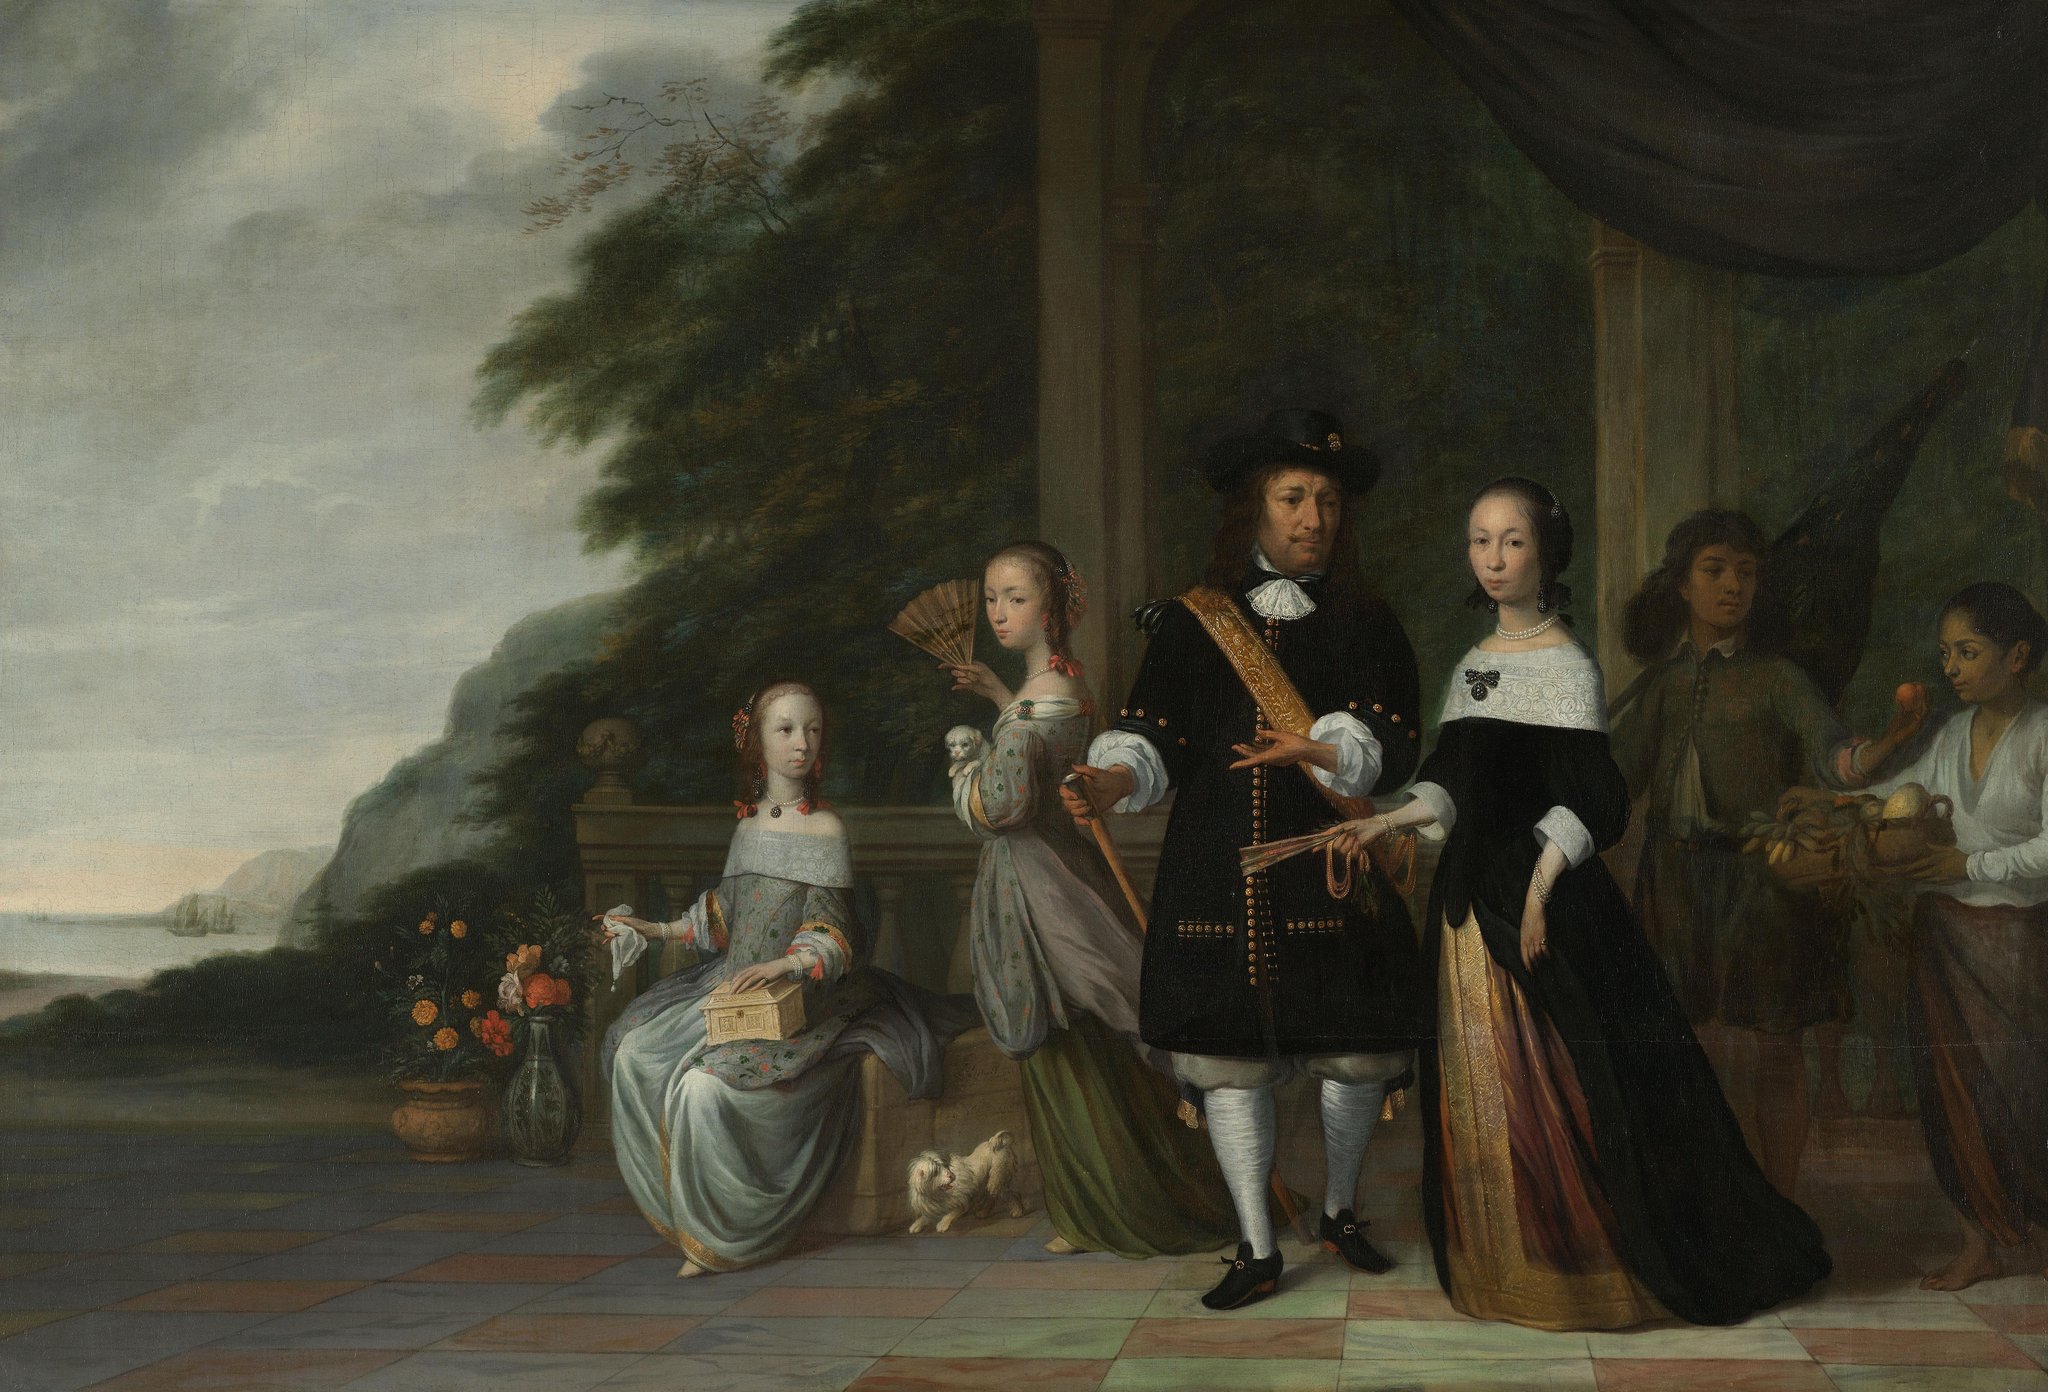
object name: painting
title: Pieter Cnoll. Senior Merchant of Batavia, his Wife Cornelia van Nijenroode and their Daughters Catharina (b. 1653) en Hester (b. 1659)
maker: jacob coeman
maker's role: painter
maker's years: -1676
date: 1665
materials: canvas, oil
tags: netherlands, batavia, family group, especially parents with their child(ren), fan, slavery; serfs and enslaved persons, flowers in a vase, house personnel, servants, dog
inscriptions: signature and date: ‘J. Coeman fec. Batt.a 1665.’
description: Cornelia van Nijenrode was the daughter of a Japanese courtesan and a Dutch East India Company (VOC) merchant. She was married to the wealthy senior VOC merchant Cnoll. In the background is Surapati, one of their servants. He fled slavery several years after he was portrayed here. First, he fought in the service of the VOC, but later against it. Surapati then became a monarch in East Java and centuries later was proclaimed Indonesia’s national hero.